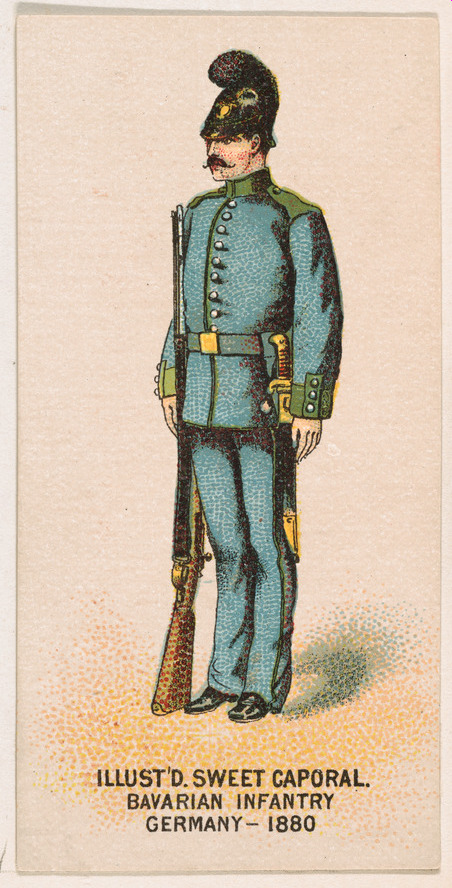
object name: print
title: Bavarian Infantry, Germany, 1880, from the Military Series (N224) issued by Kinney Tobacco Company to promote Sweet Caporal Cigarettes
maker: kinney brothers tobacco company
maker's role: publisher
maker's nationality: american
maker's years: 1869-2011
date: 1888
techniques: color lithograph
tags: military,men